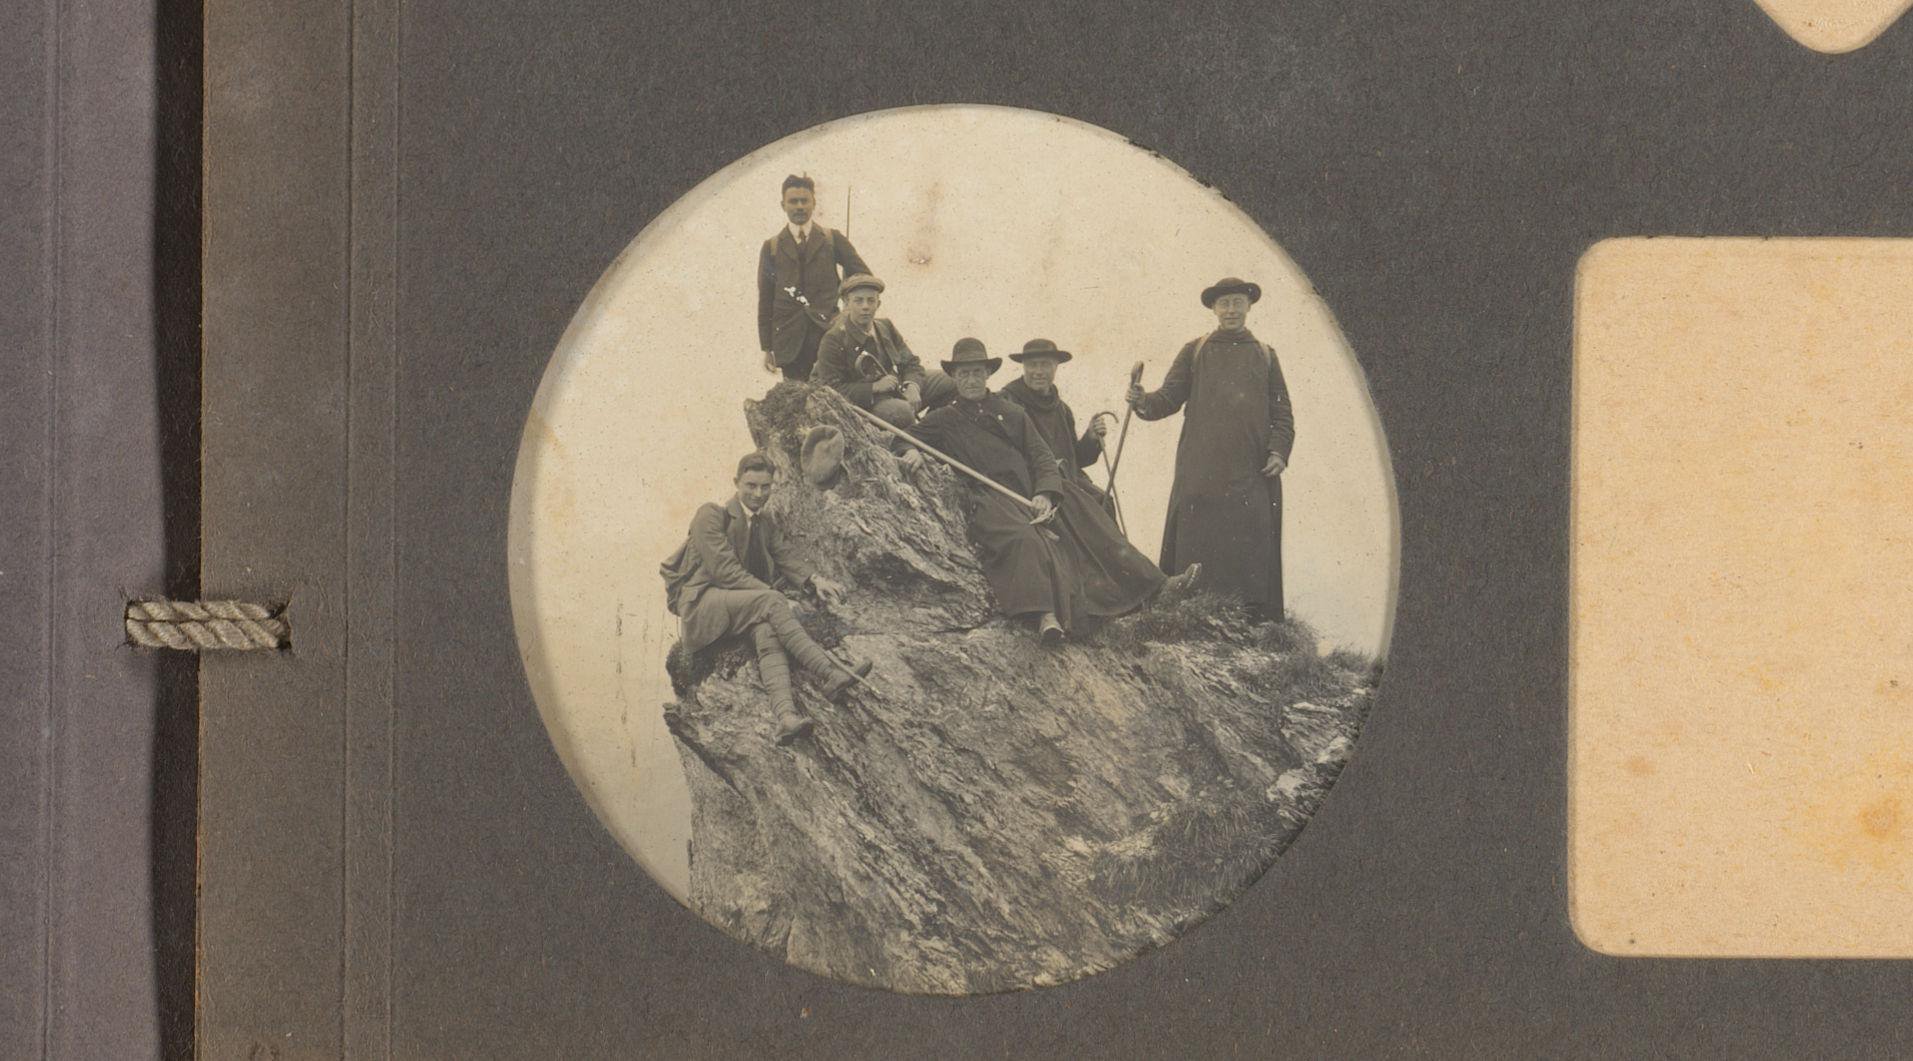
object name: album leaf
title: Groep mannen op een bergpiek, links Jan Hellendoorn, Miel en een onbekende jonge man, rechts drie paters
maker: Anonymous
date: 1908-1912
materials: paper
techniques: gelatin silver print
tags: mountain-top, peak, youth, adolescent, organization, functionaries and dignitaries in roman catholic church; clergy in general